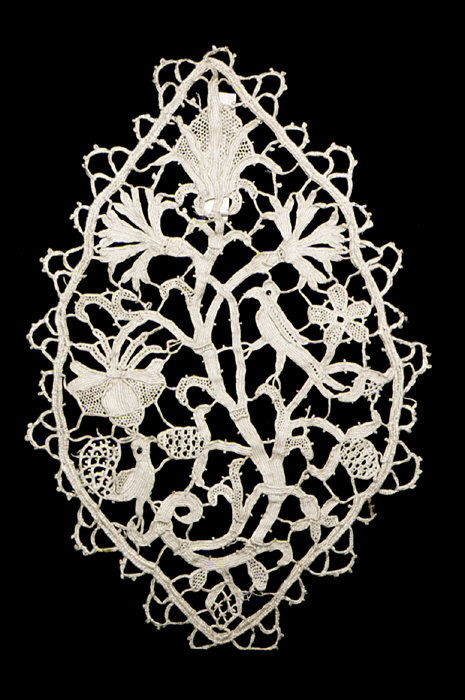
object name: ornament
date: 1601-1700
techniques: lace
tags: birds,flowers